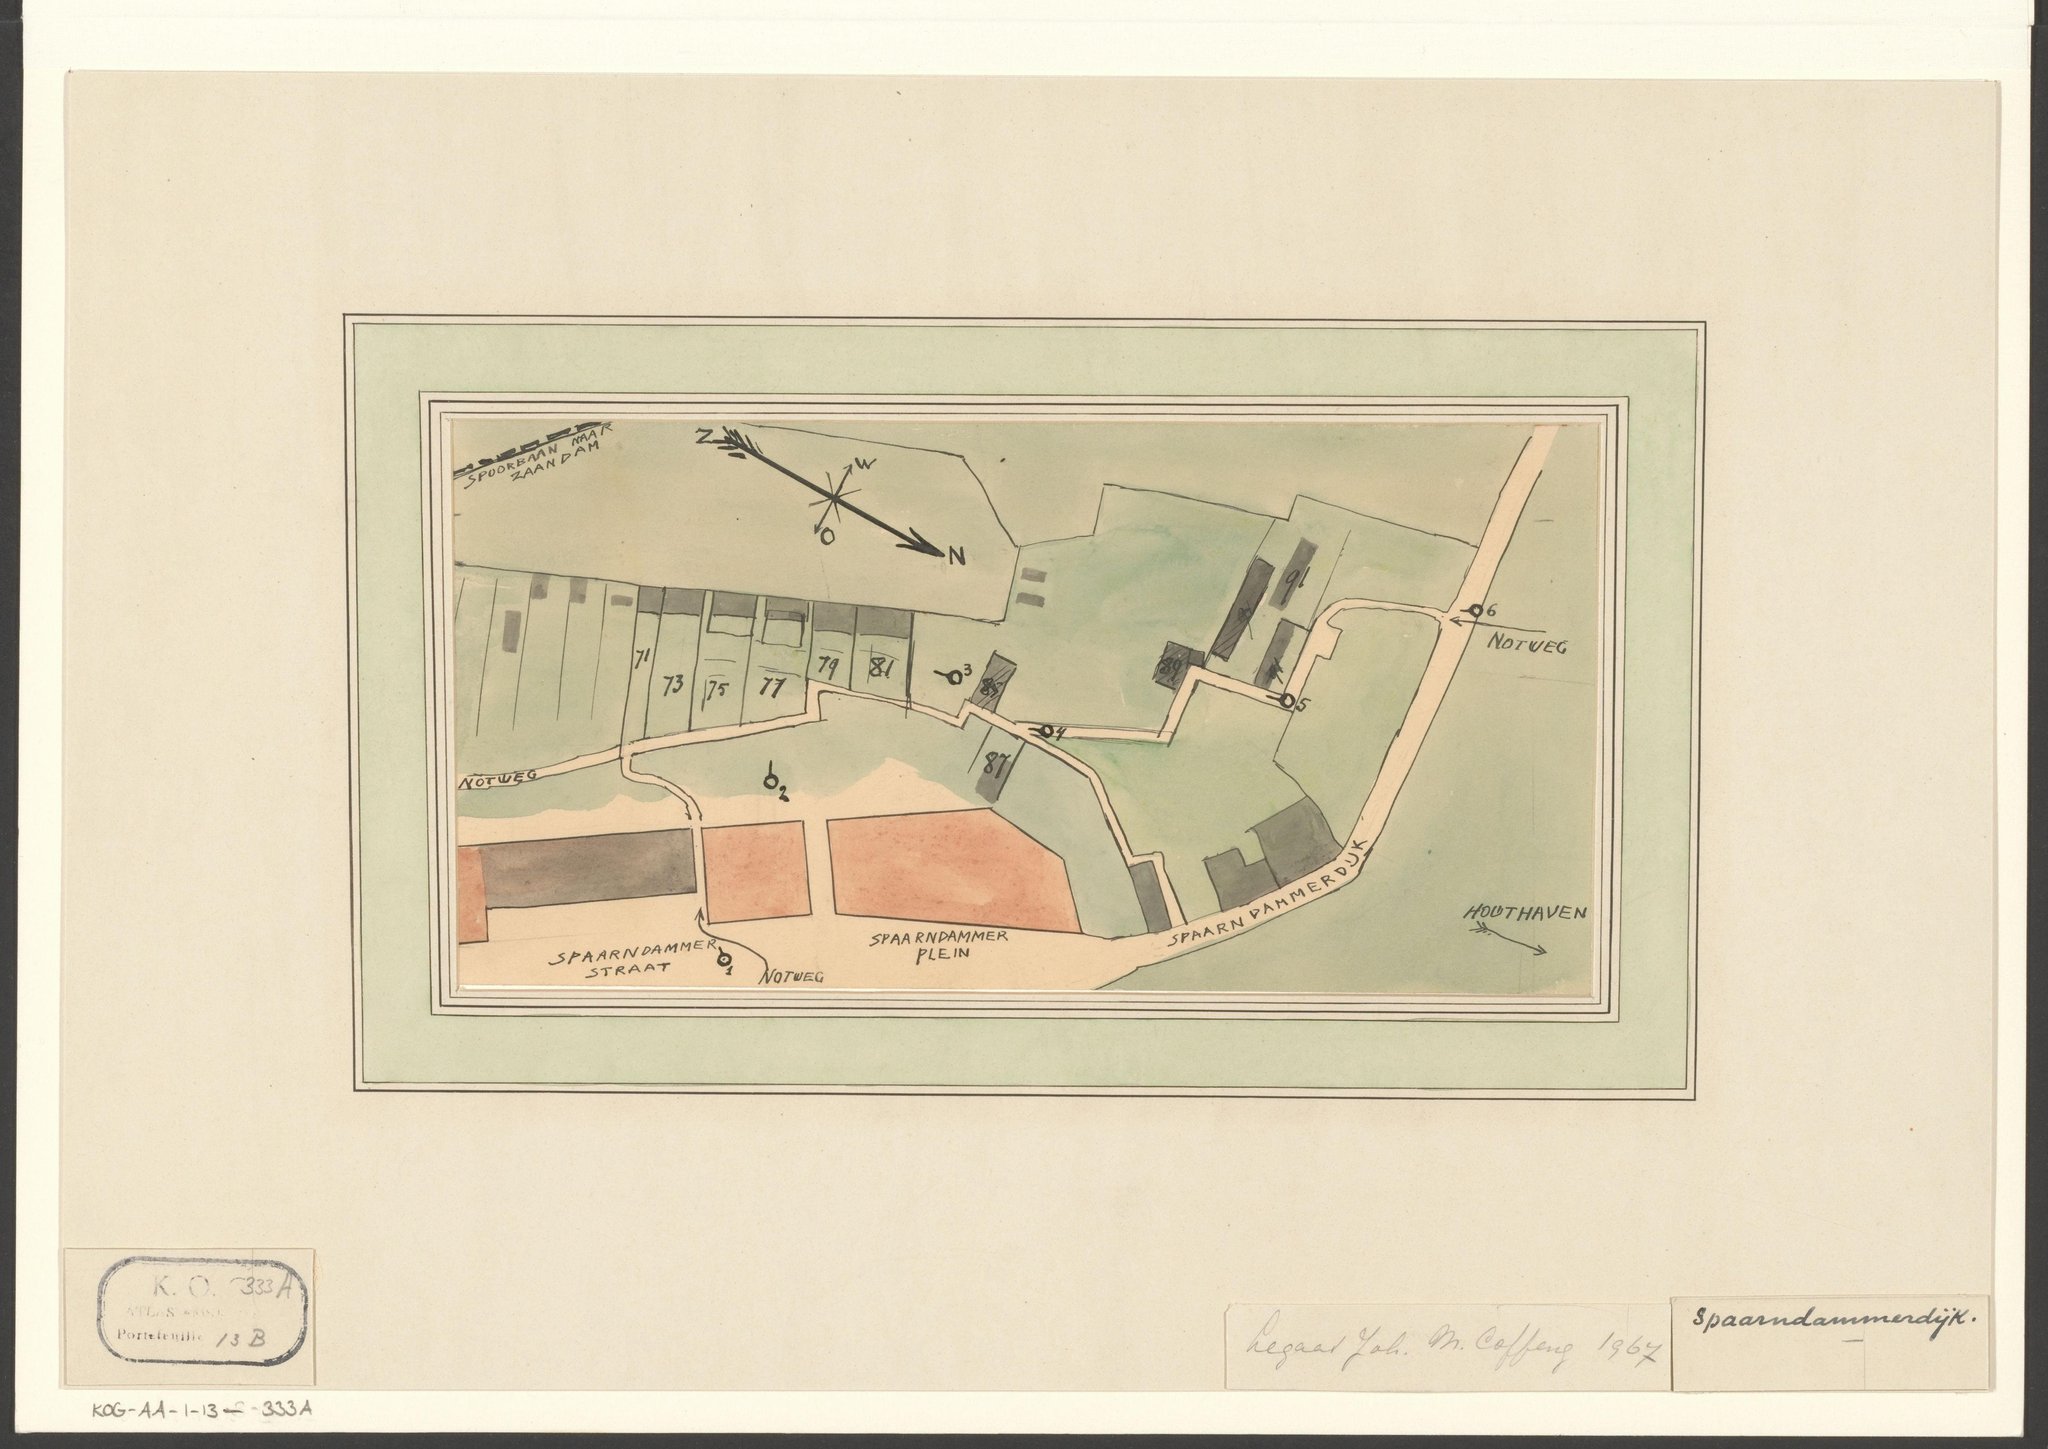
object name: area plan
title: Plattegrond van de omgeving Spaarndammerdijk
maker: Anonymous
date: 1850-1950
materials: ink, paper, pencil, watercolor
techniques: brush, pen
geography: amsterdam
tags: city-view in general; 'veduta', maps of cities, street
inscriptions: collector's mark: ‘13B’ Lugt 1641b, inscription: ‘Legaat Joh. M. Coffeng 1967 / Spaarndammerdijk.’, inscription: ‘Port. 13-333a’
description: Onderwerpsrubriek binnen de Atlas Amsterdam: Slatuinenpad, Sloterkade, Slootstraat, Slijkstraat, Snoekjesgracht, Sophiapark, Spaarndammerdijk, Spiegelgracht, Spinhuissteeg, Spui, Spuistraat (ook lage Erf), Staalstraat, Stadhouderskade, Steenpad, Stroomarkt.